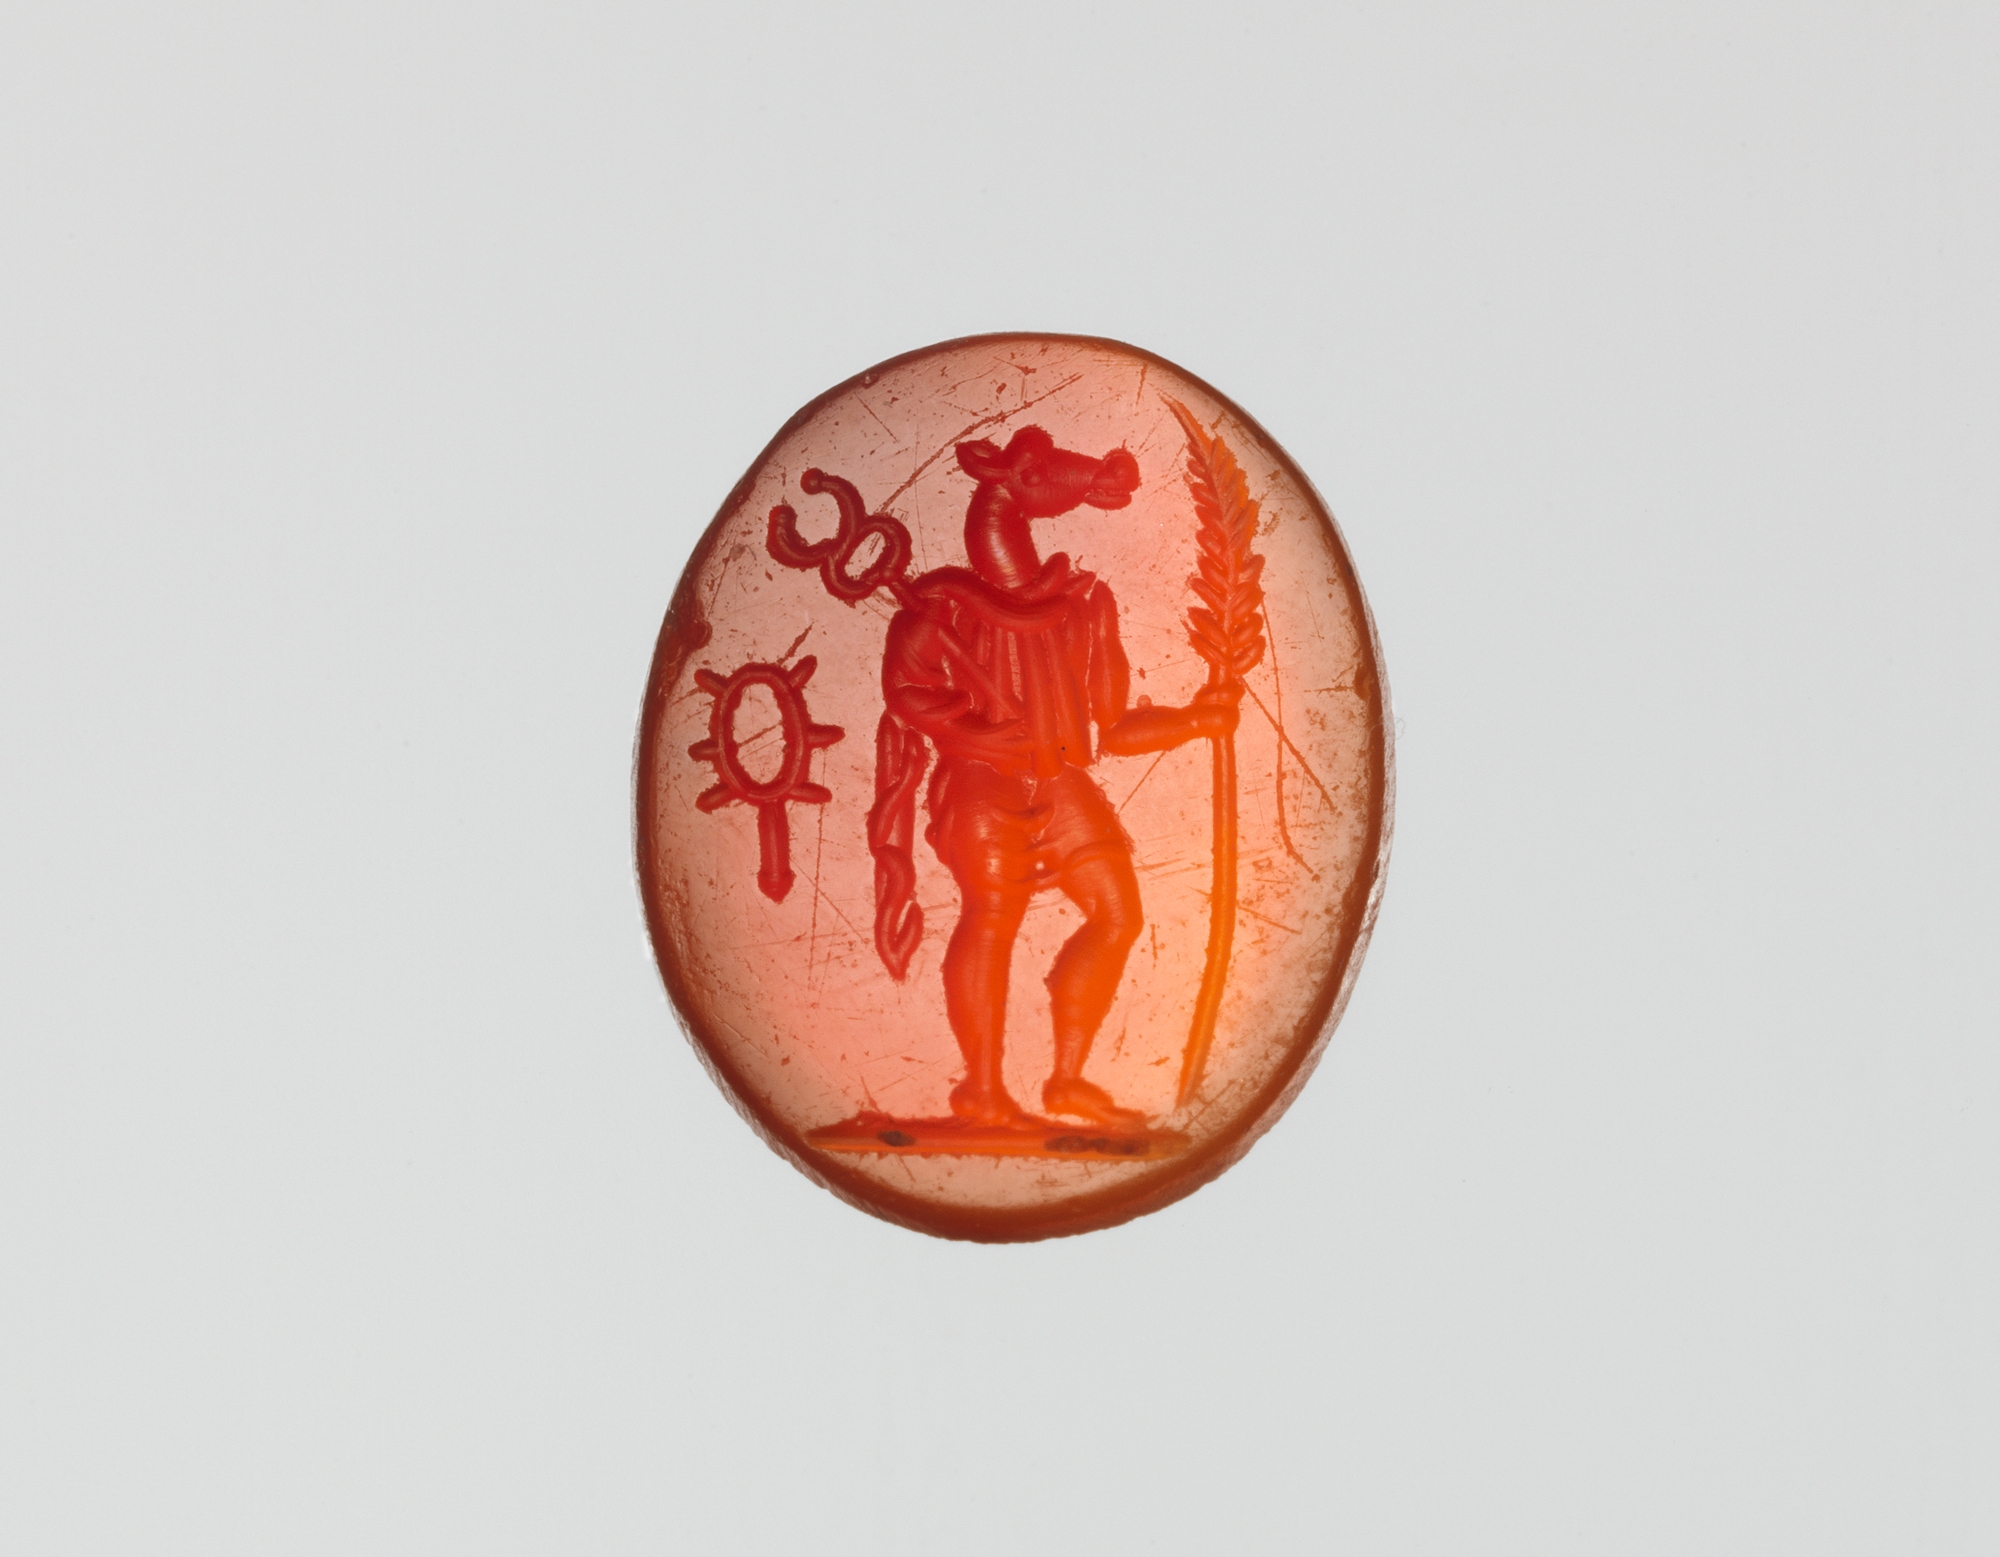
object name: intaglio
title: Carnelian intaglio: Standing Anubis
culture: roman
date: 101-300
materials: gemstone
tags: anubis